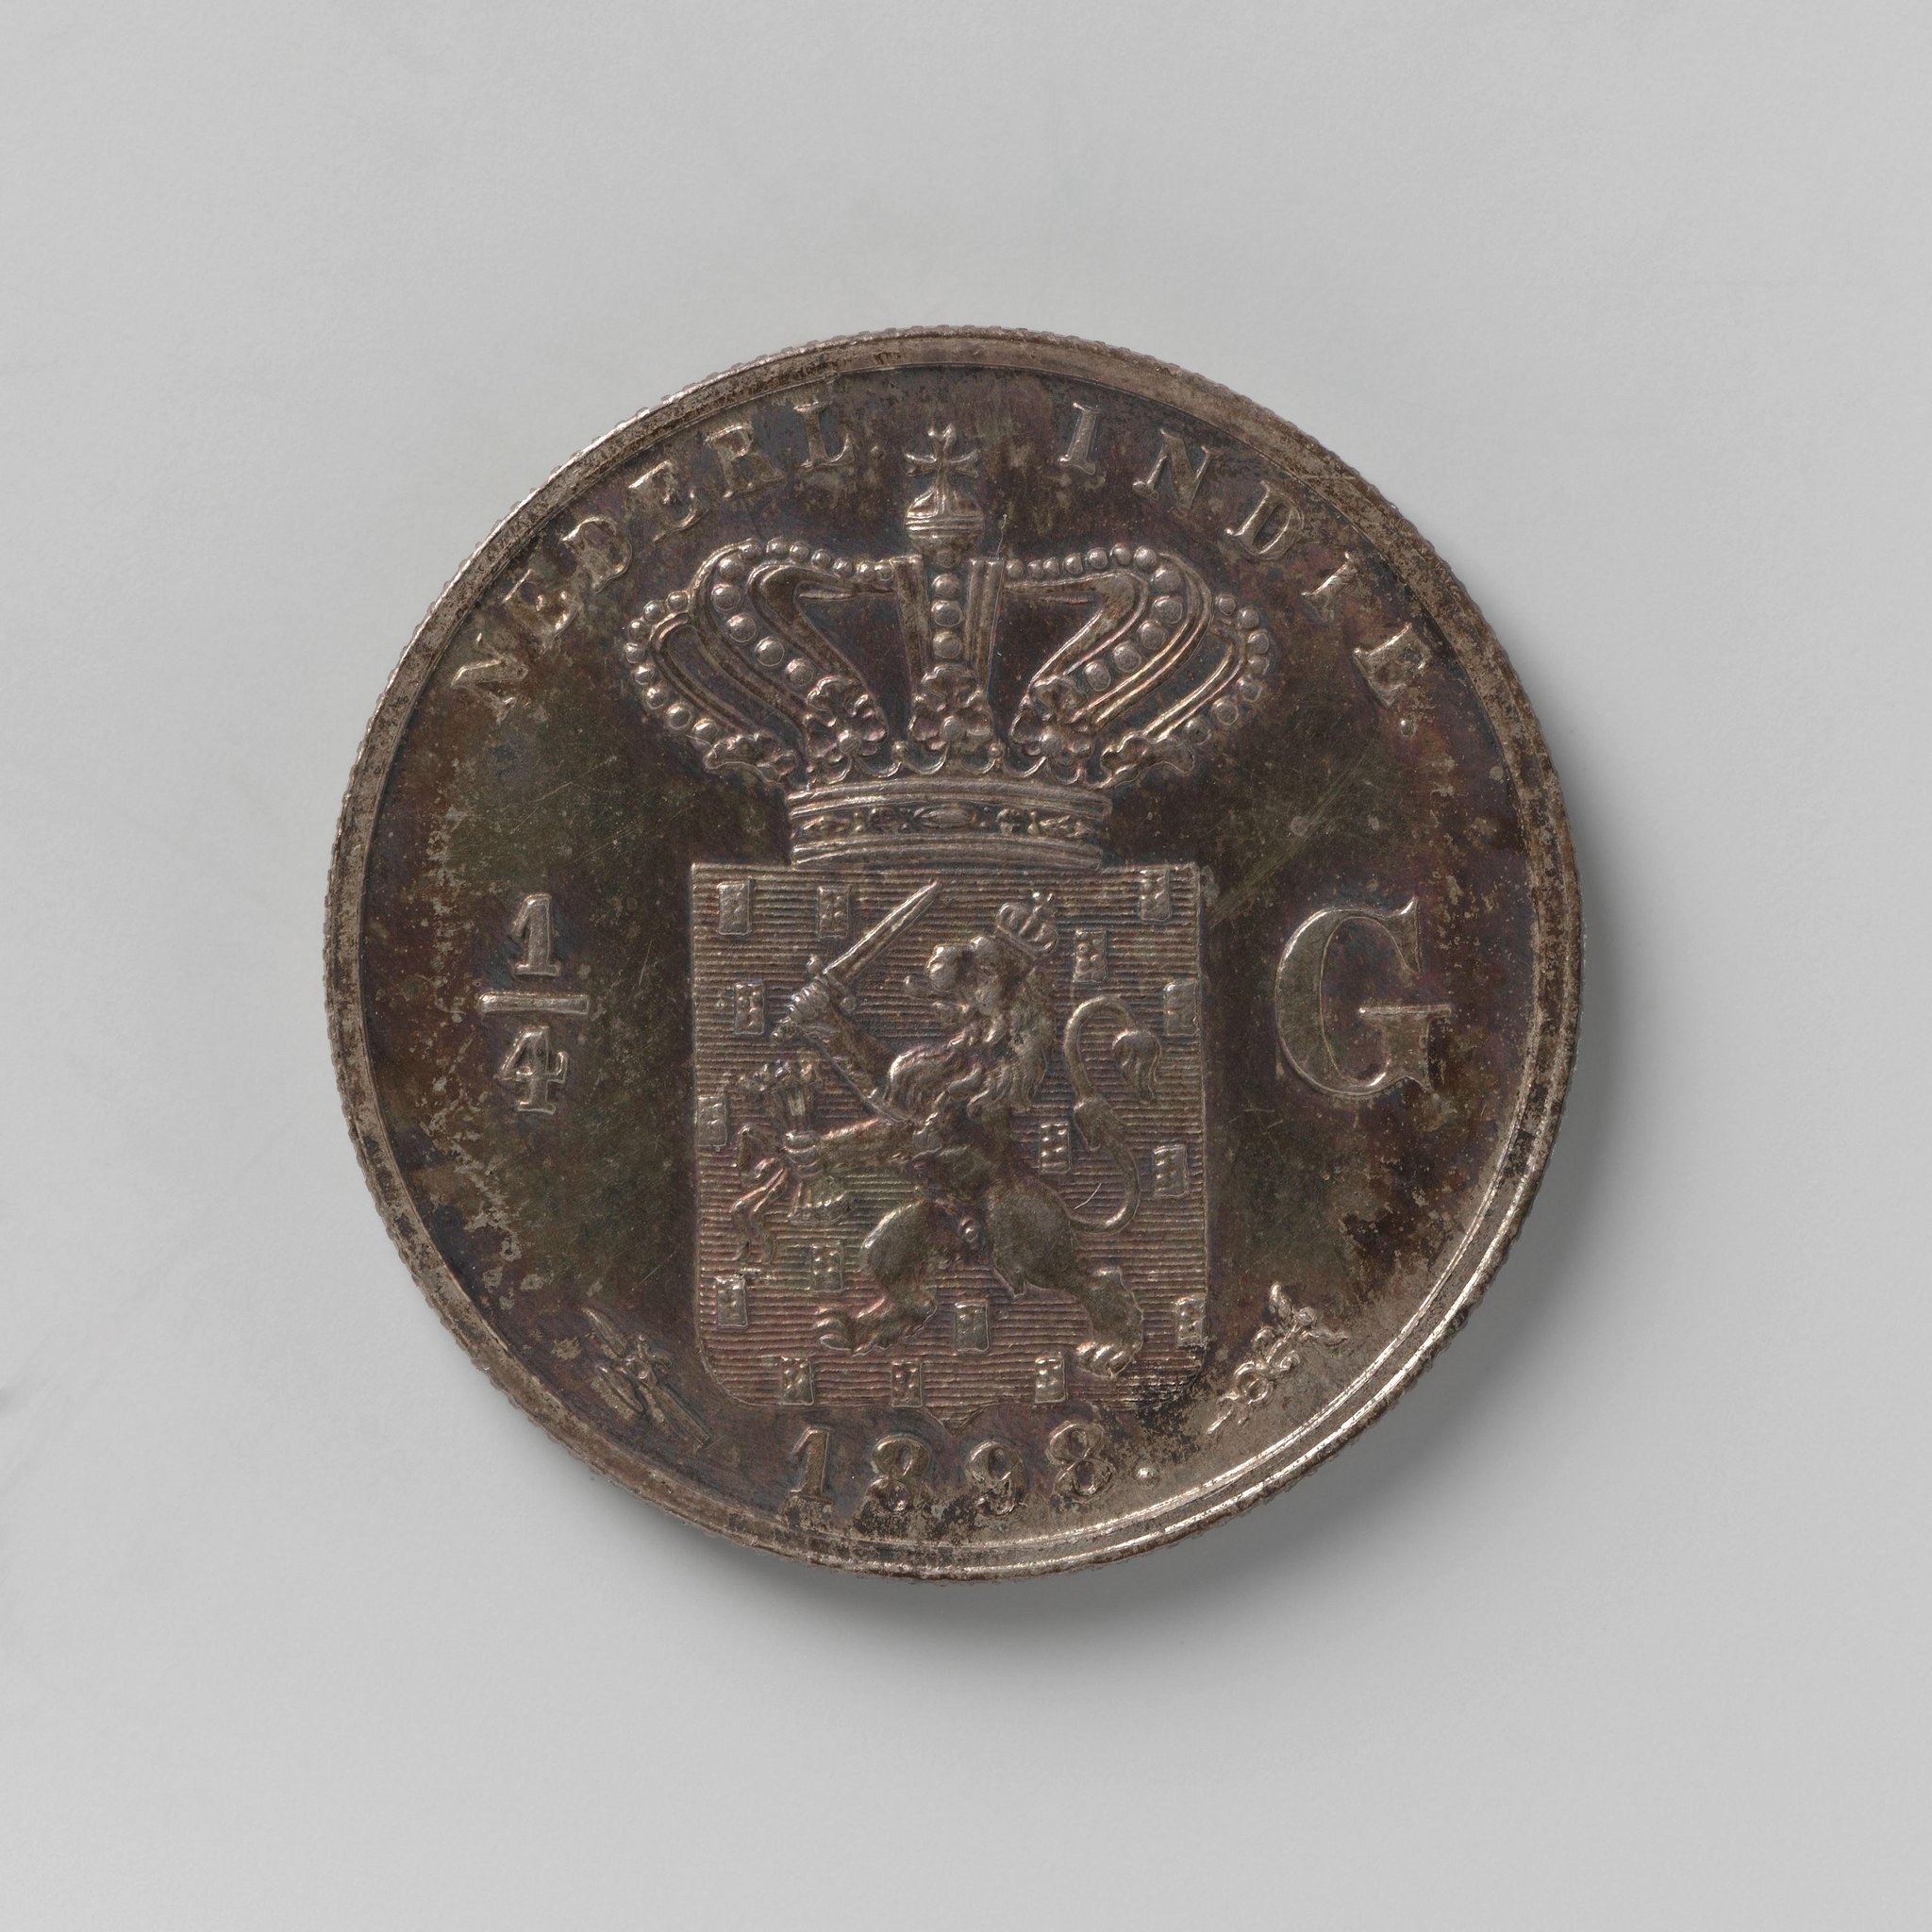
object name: coin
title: 1/4 gulden van Nederlands Indië,1898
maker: wilhelmina of the netherlands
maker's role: print maker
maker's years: 1880-1962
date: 1898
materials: silver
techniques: striking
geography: utrecht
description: Zilveren munt. Voorzijde: tussen waarde-aanduiding 1/4 G gekroond rijkswapenschild. Boven kroon landsaanduiding en onder wapenschild jaartal. Keerzijde: drieregelig Maleis opschrift in Arabische tekens, waaromheen tussen zeven uitschietende stralen omschrift in het Javaans. Kartelrand.